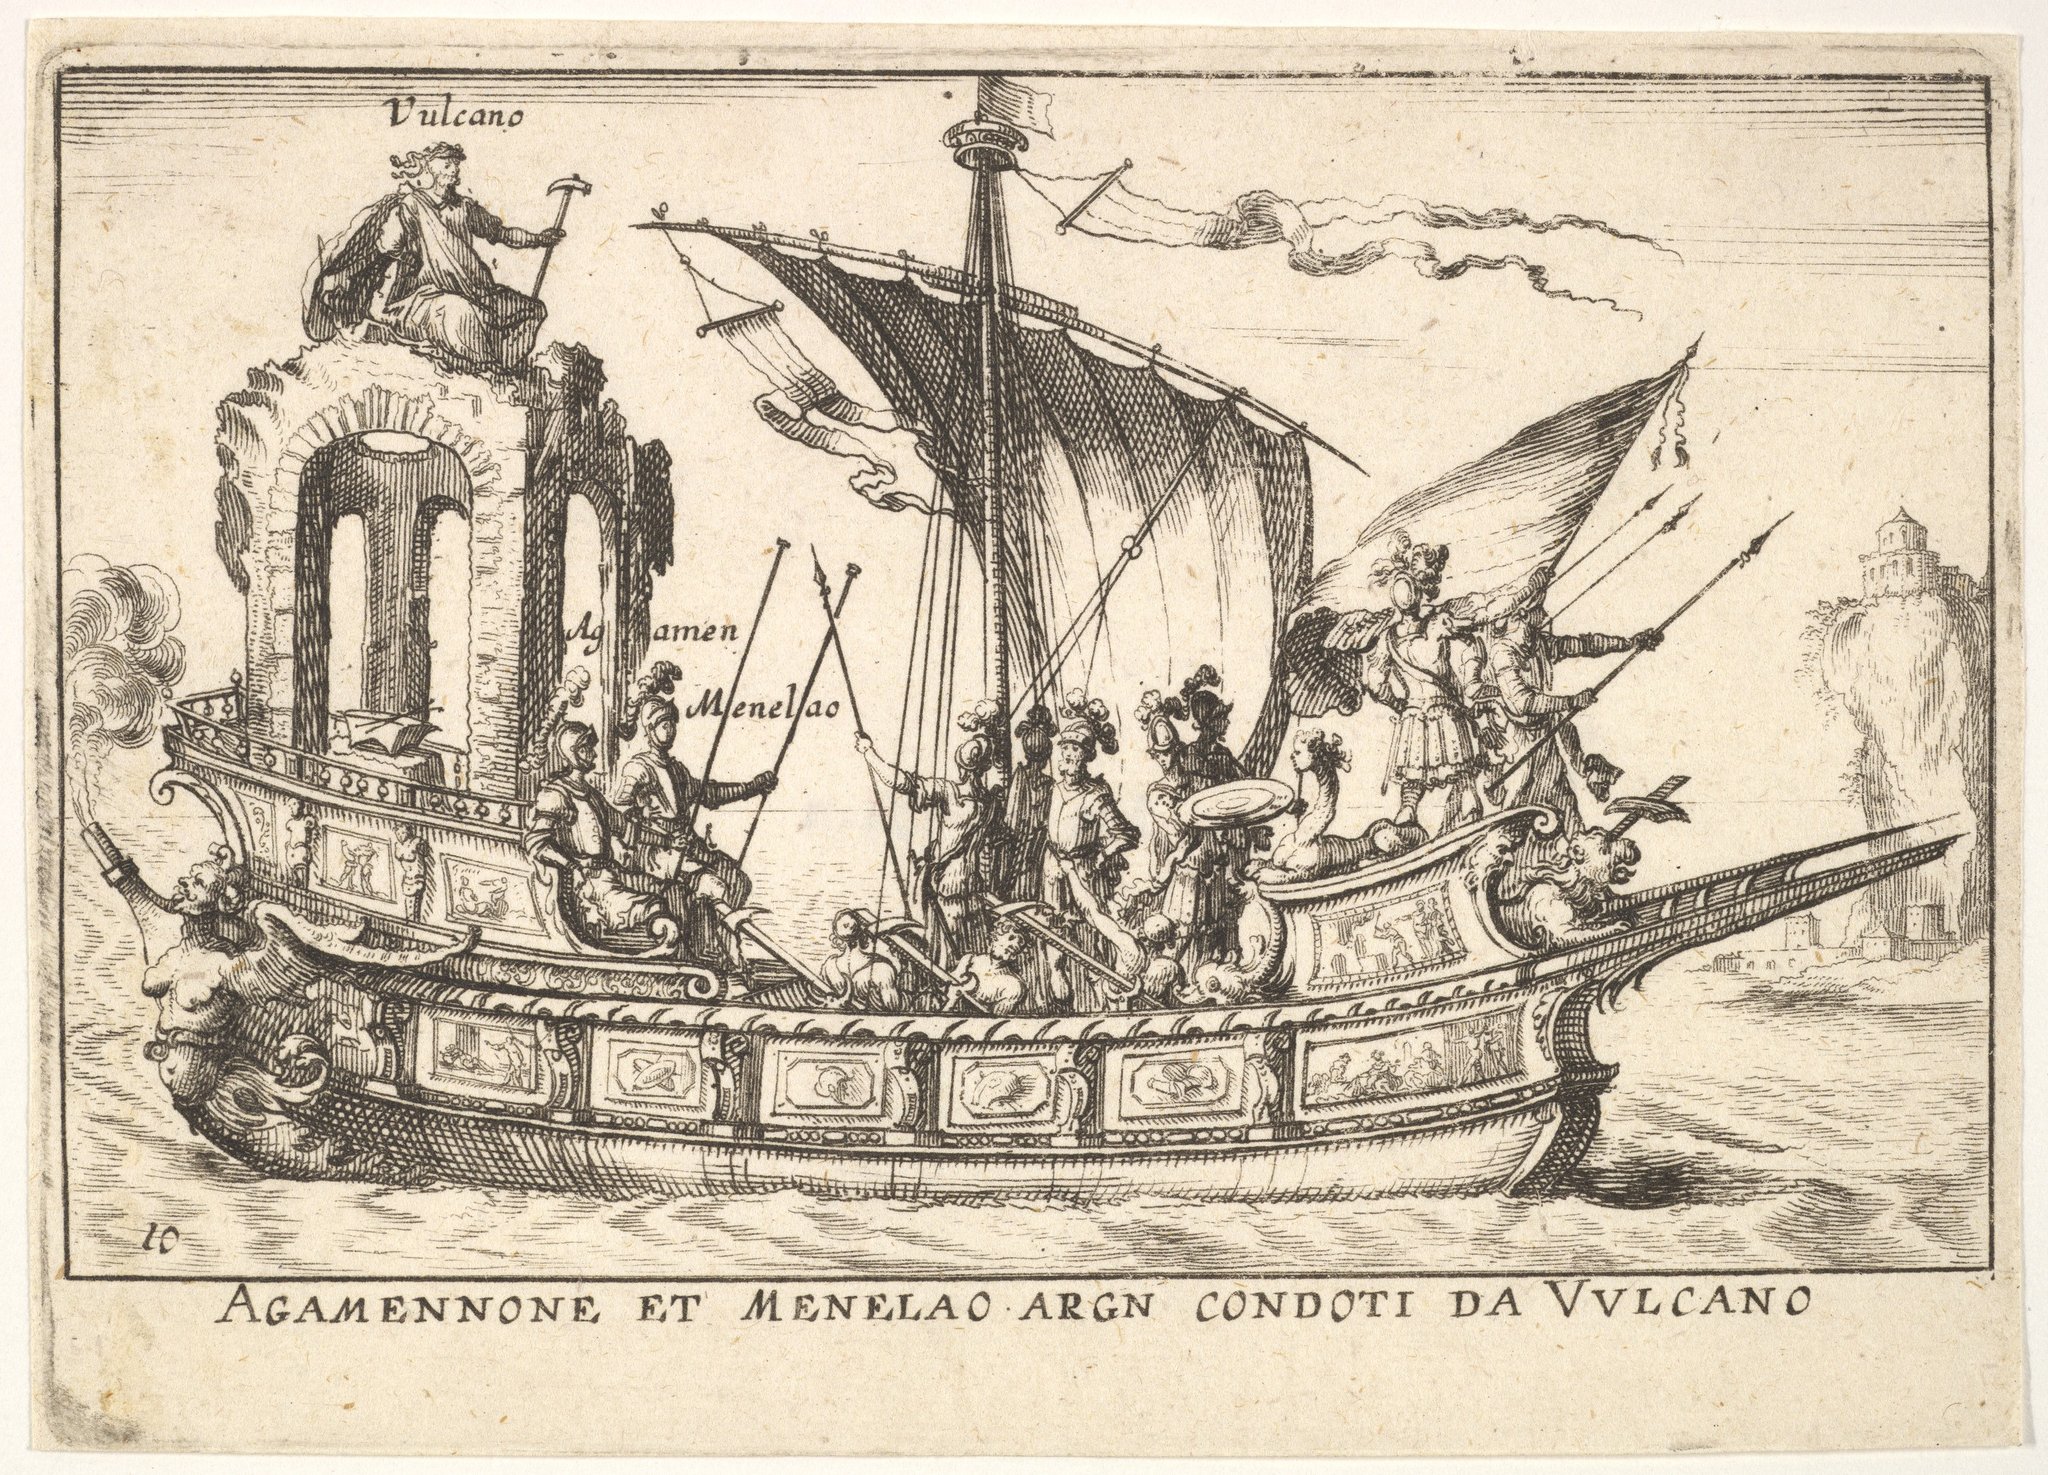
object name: print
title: Plate 10: Agamemnon and Menelaus seated in a boat accompanied by other figures including Vulcan (Agamennone et Menelao Argn. condoti da Vulcano), from "The magnificent pageant on the river Arno in Florence for the marriage of the Grand Duke" (Le Magnifique carousel fait sur le fleuve de l'Arne a Florence, pour le mariage du Grand Duc)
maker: Anonymous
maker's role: artist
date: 1664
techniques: etching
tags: men,vulcan,boats,menelaus,agamemnon